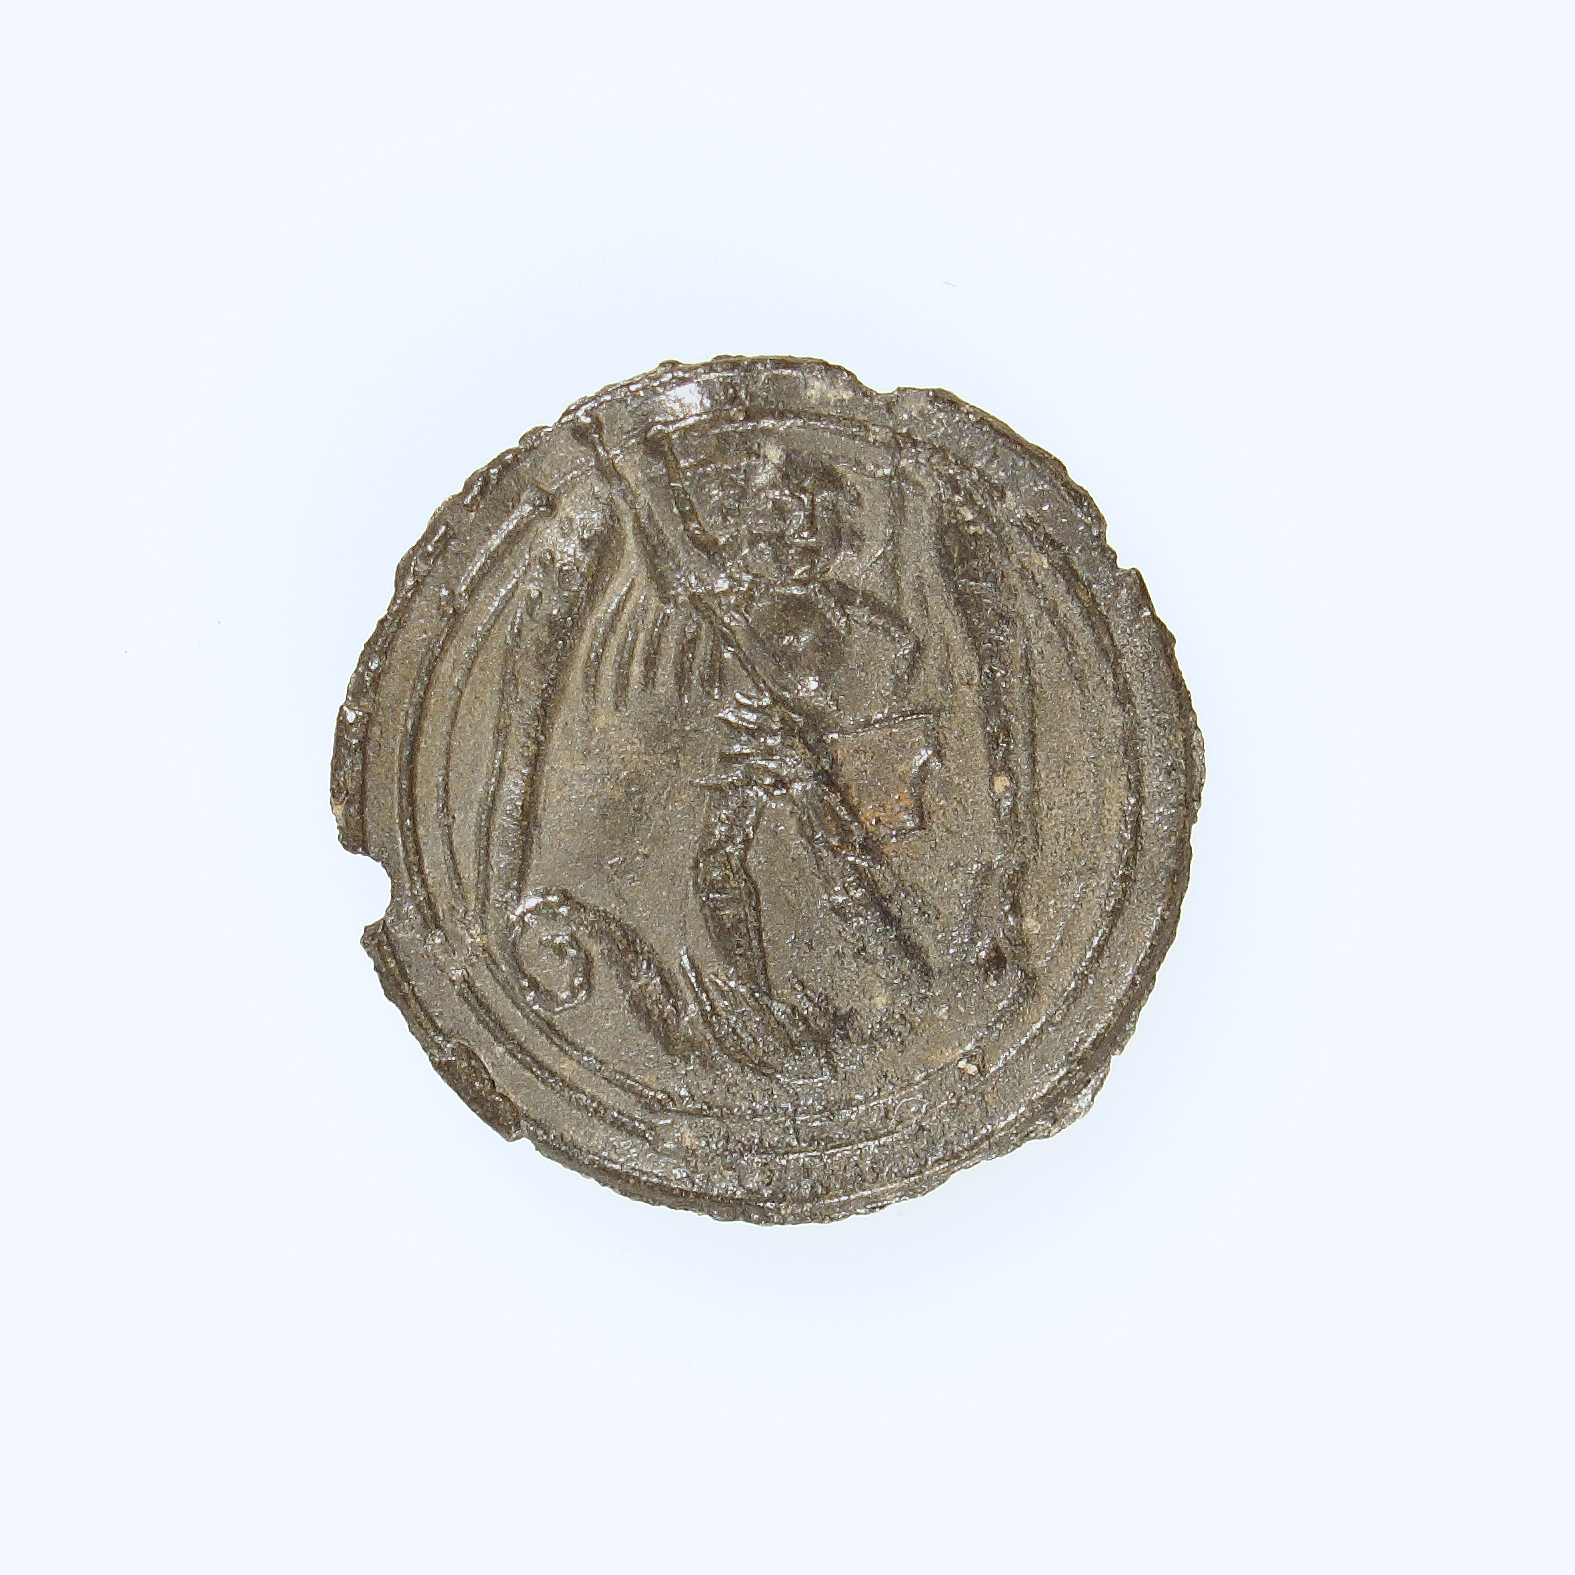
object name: pilgrim's badge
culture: french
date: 1301-1600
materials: lead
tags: saints